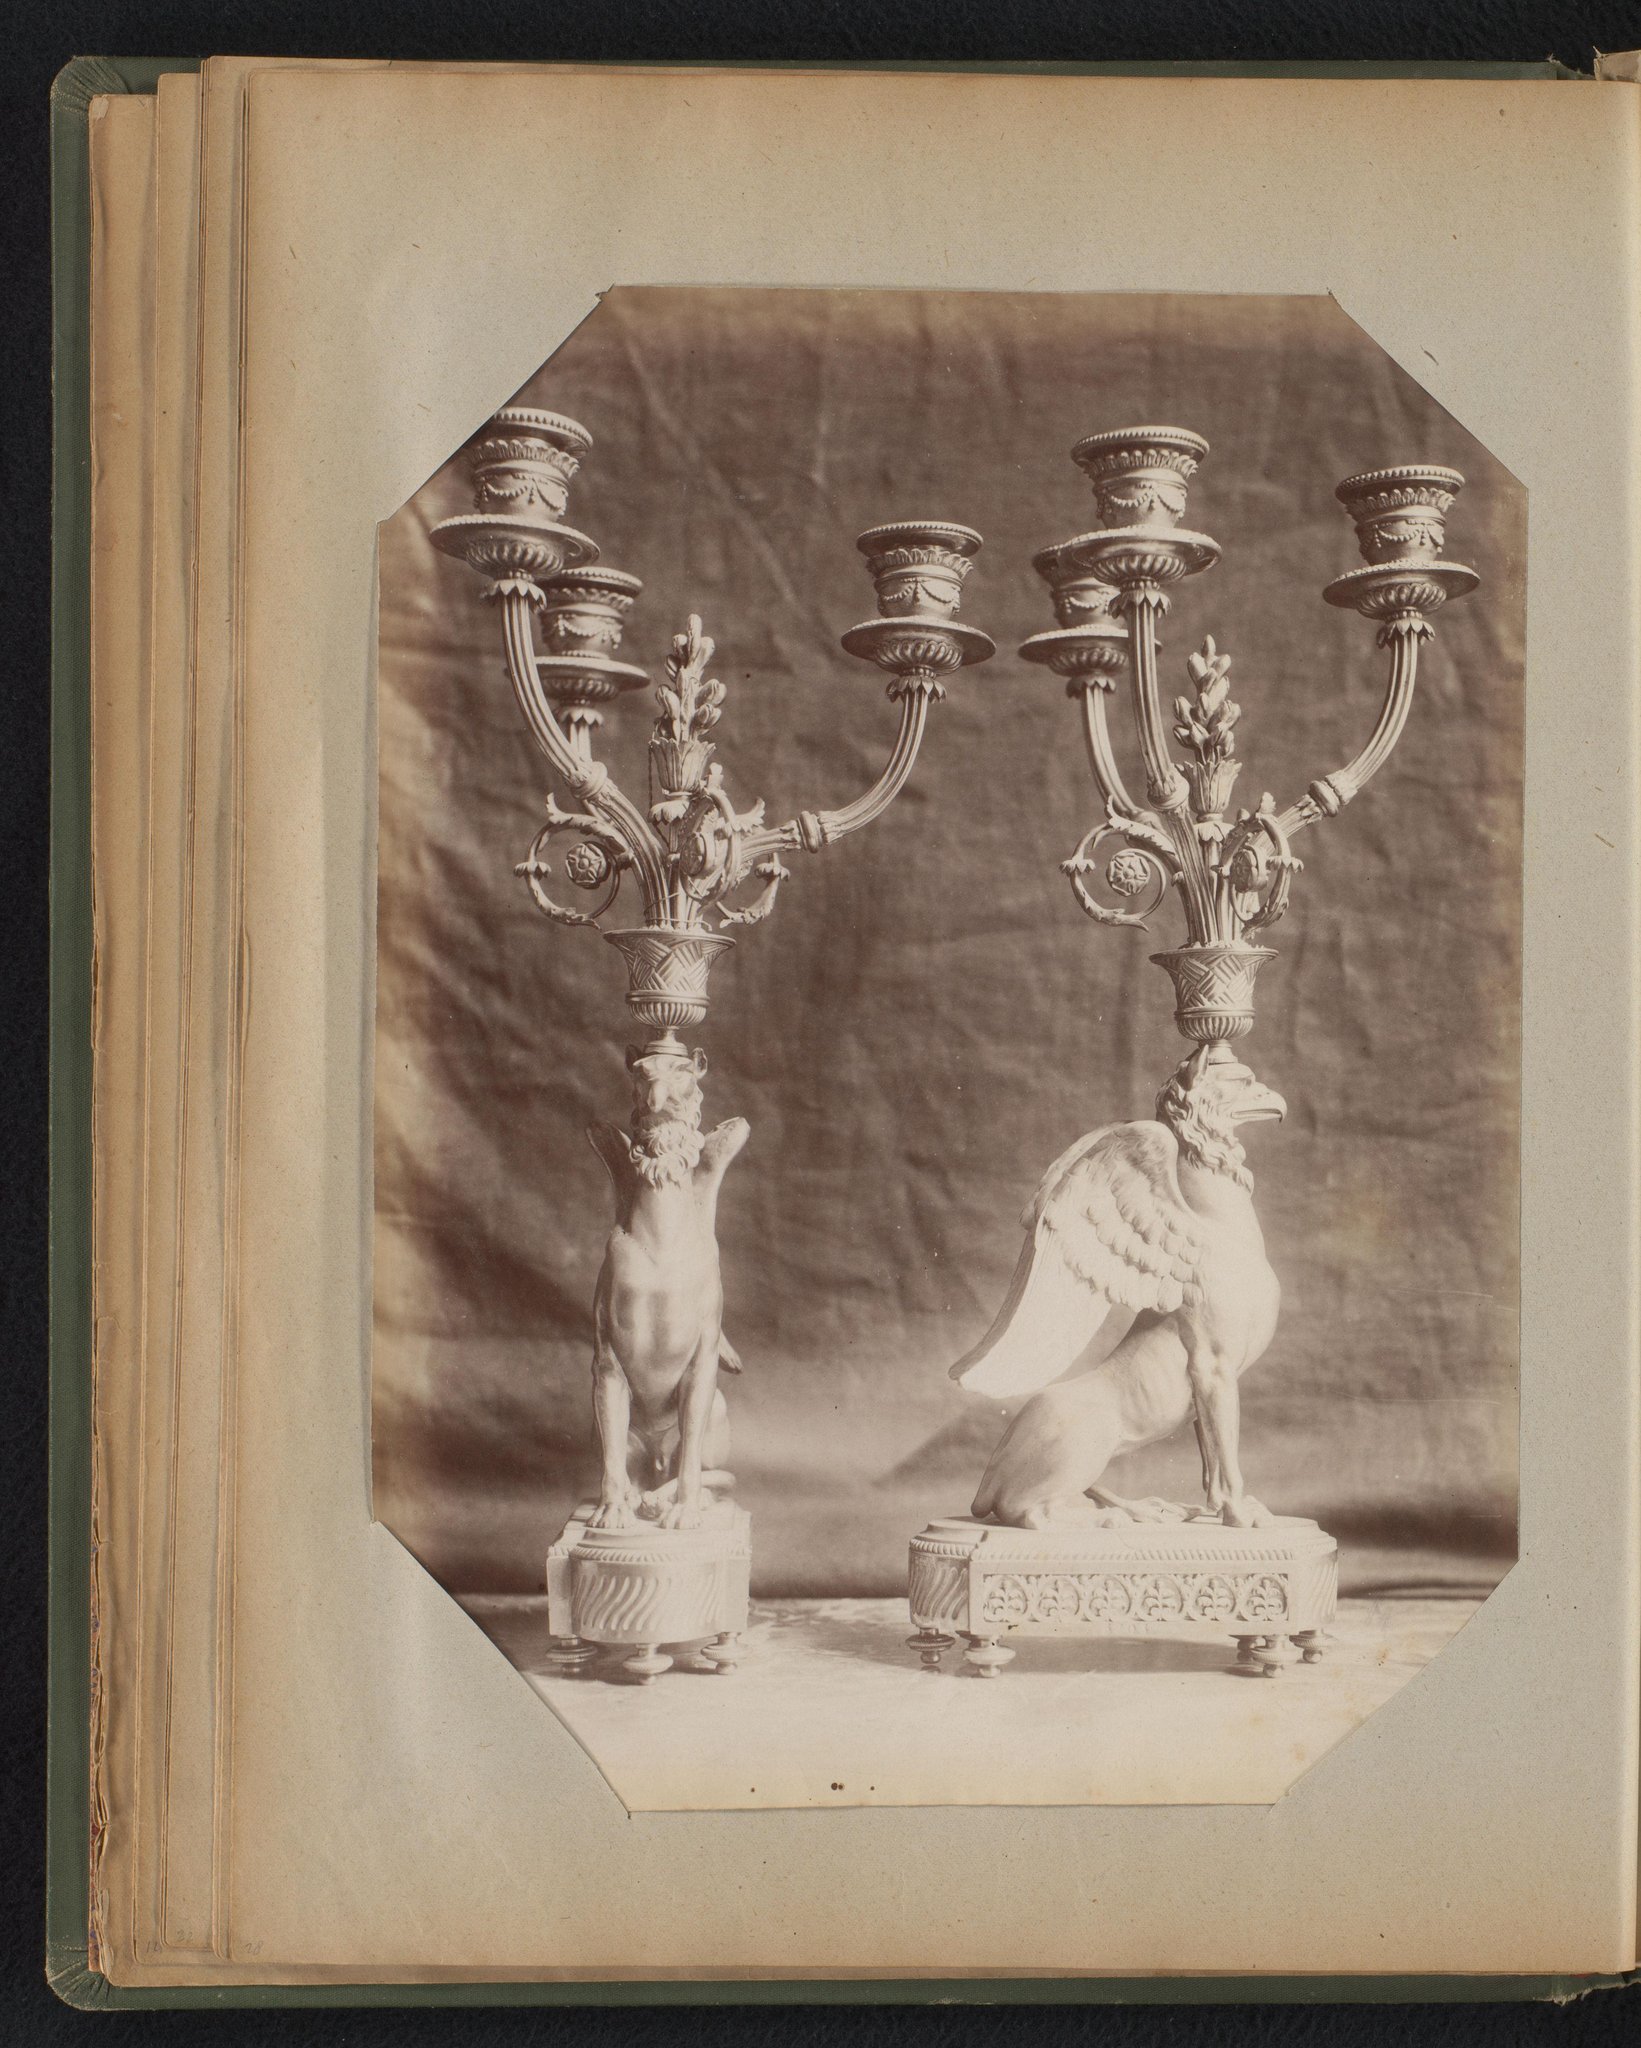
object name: photograph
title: Twee bronzen driearmige kandelaars met ieder als onderstel een bronzen griffioen op een voetstuk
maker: Anonymous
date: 1860-1900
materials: canvas, cardboard, paper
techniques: albumen print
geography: netherlands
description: Onderdeel van een serie met betrekking tot het interieur van het paleis van Versailles met kroonluchters, deuren, portalen en meubelstukken.